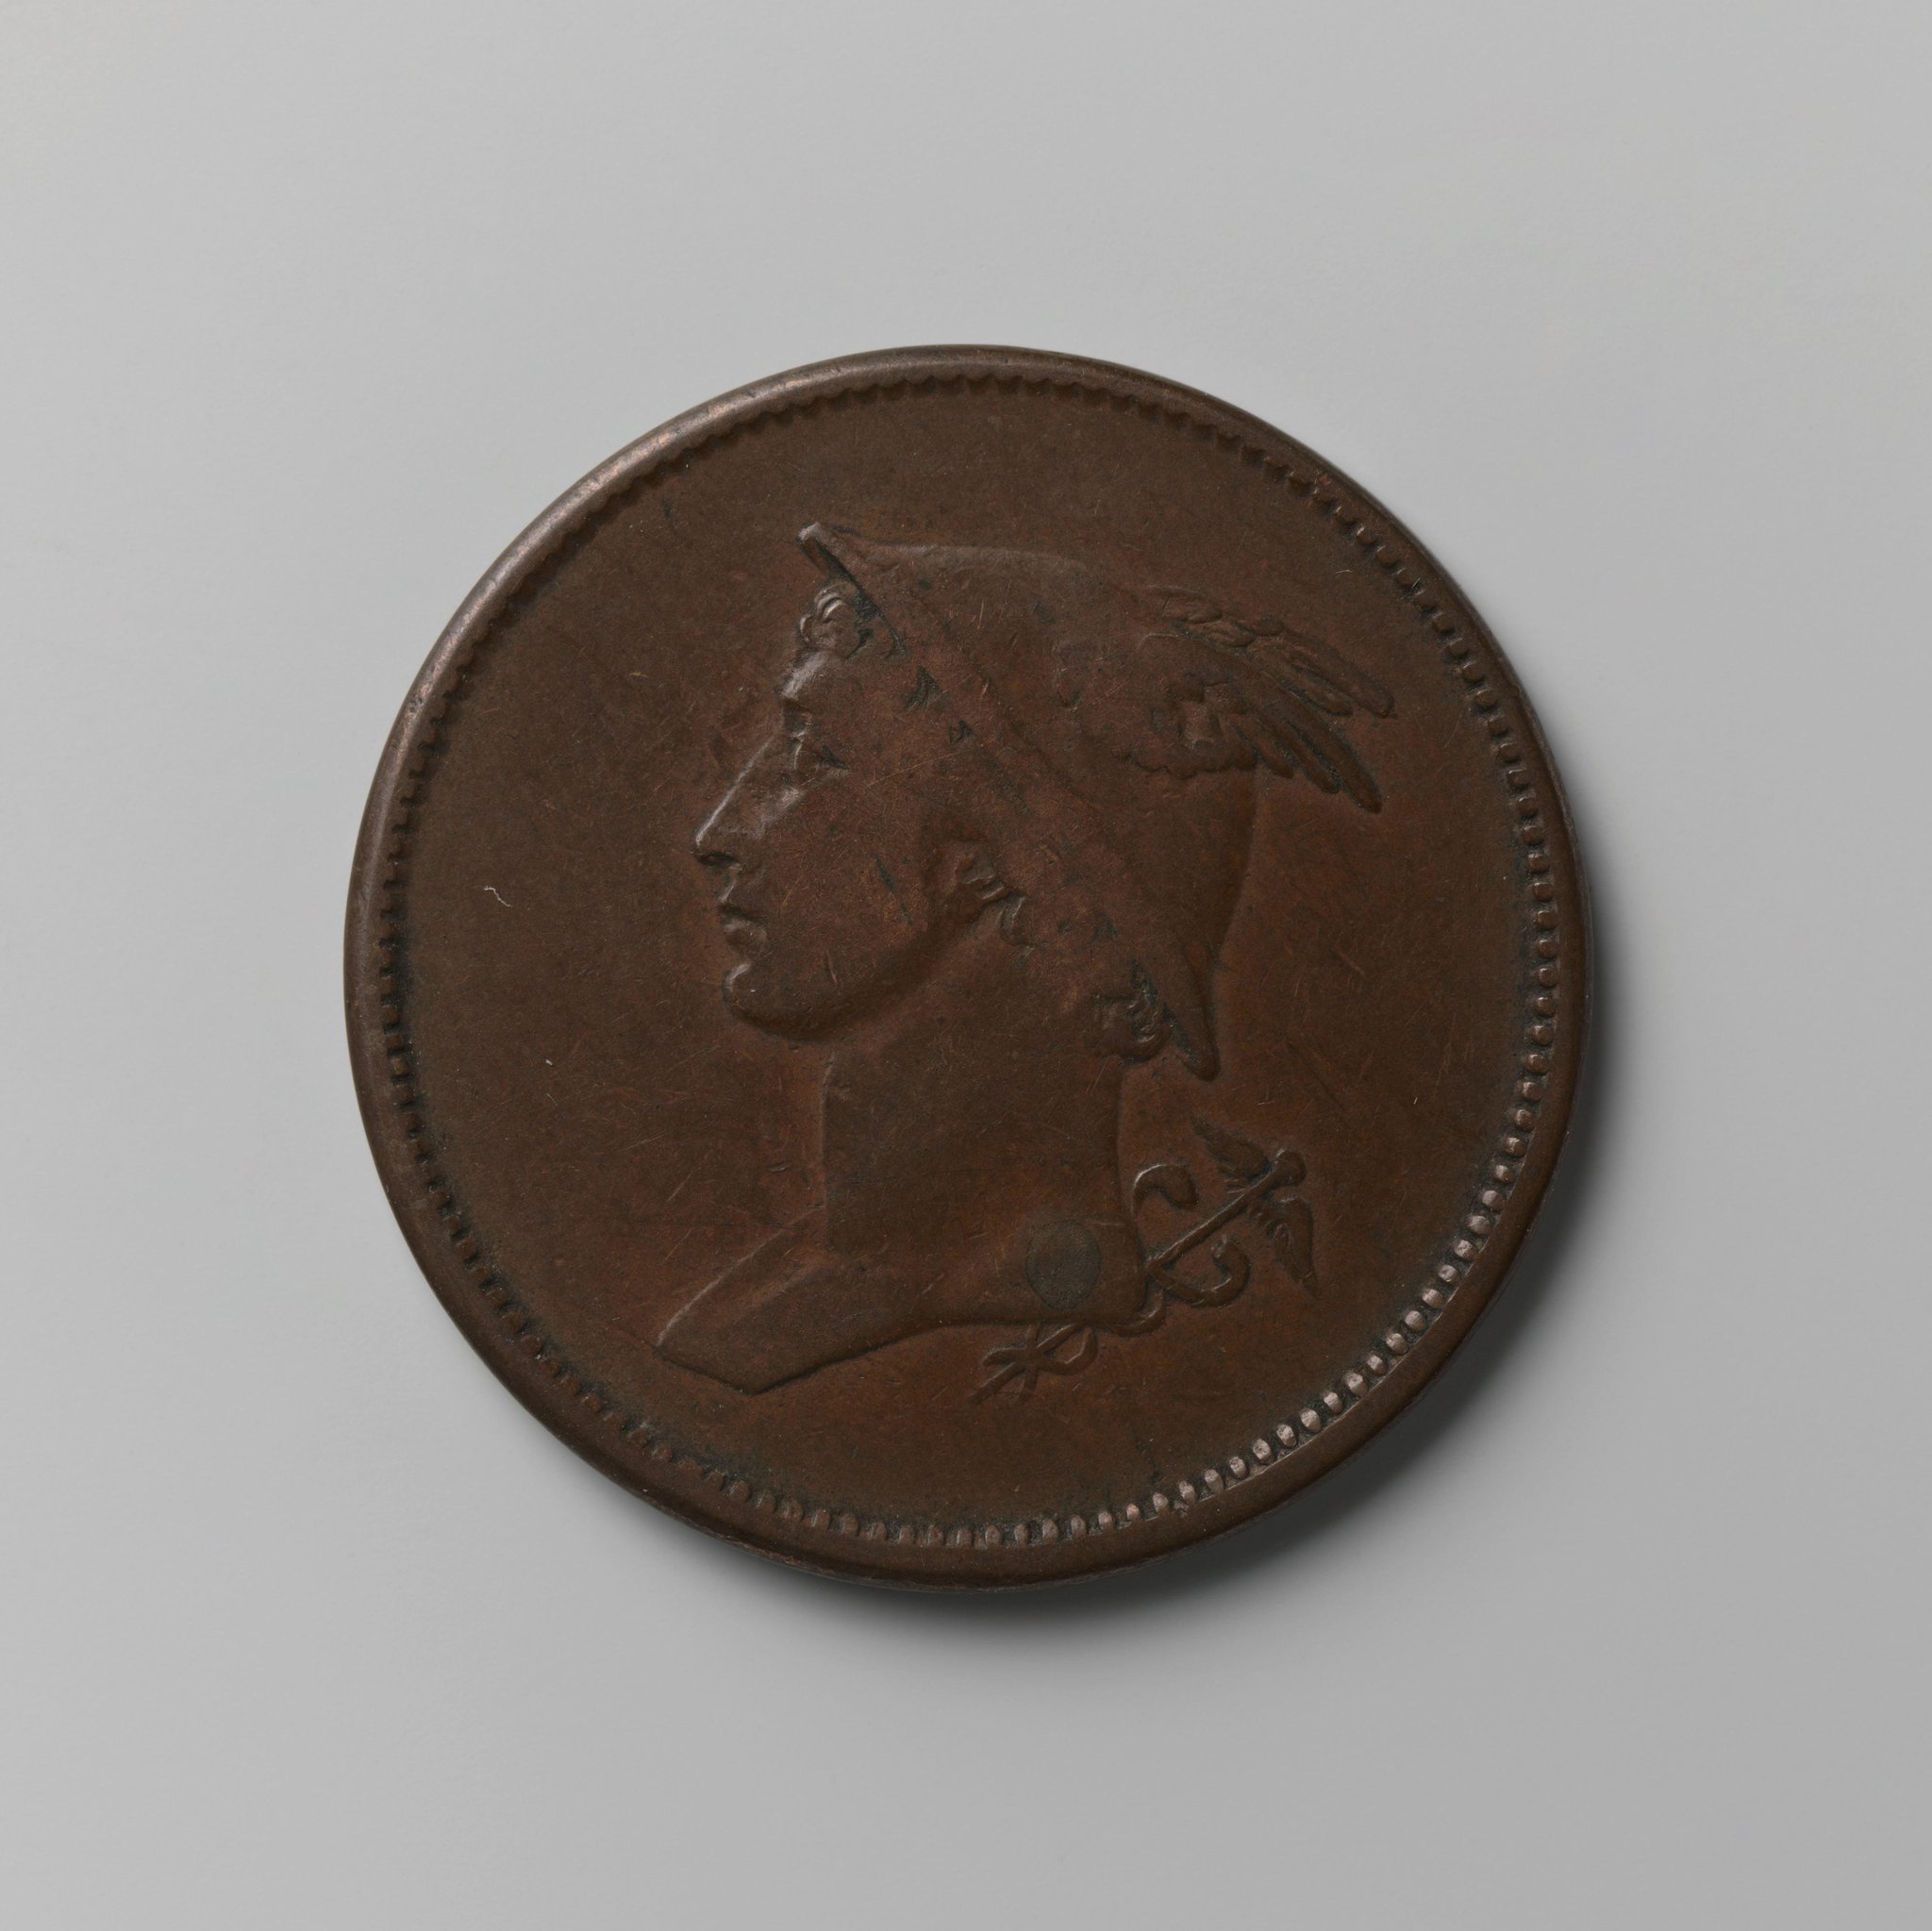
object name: halve penny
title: 1/2 penny-token, Walthamstow, Engeland, 1813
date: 1813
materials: copper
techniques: striking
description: Koperen particuliere munt. Voorzijde: binnen twee samengebonden eiketakken op schild gezeten Brittannnia met drietand en takken, naar links. Keerzijde: Mercurius met staf. Gladde rand.